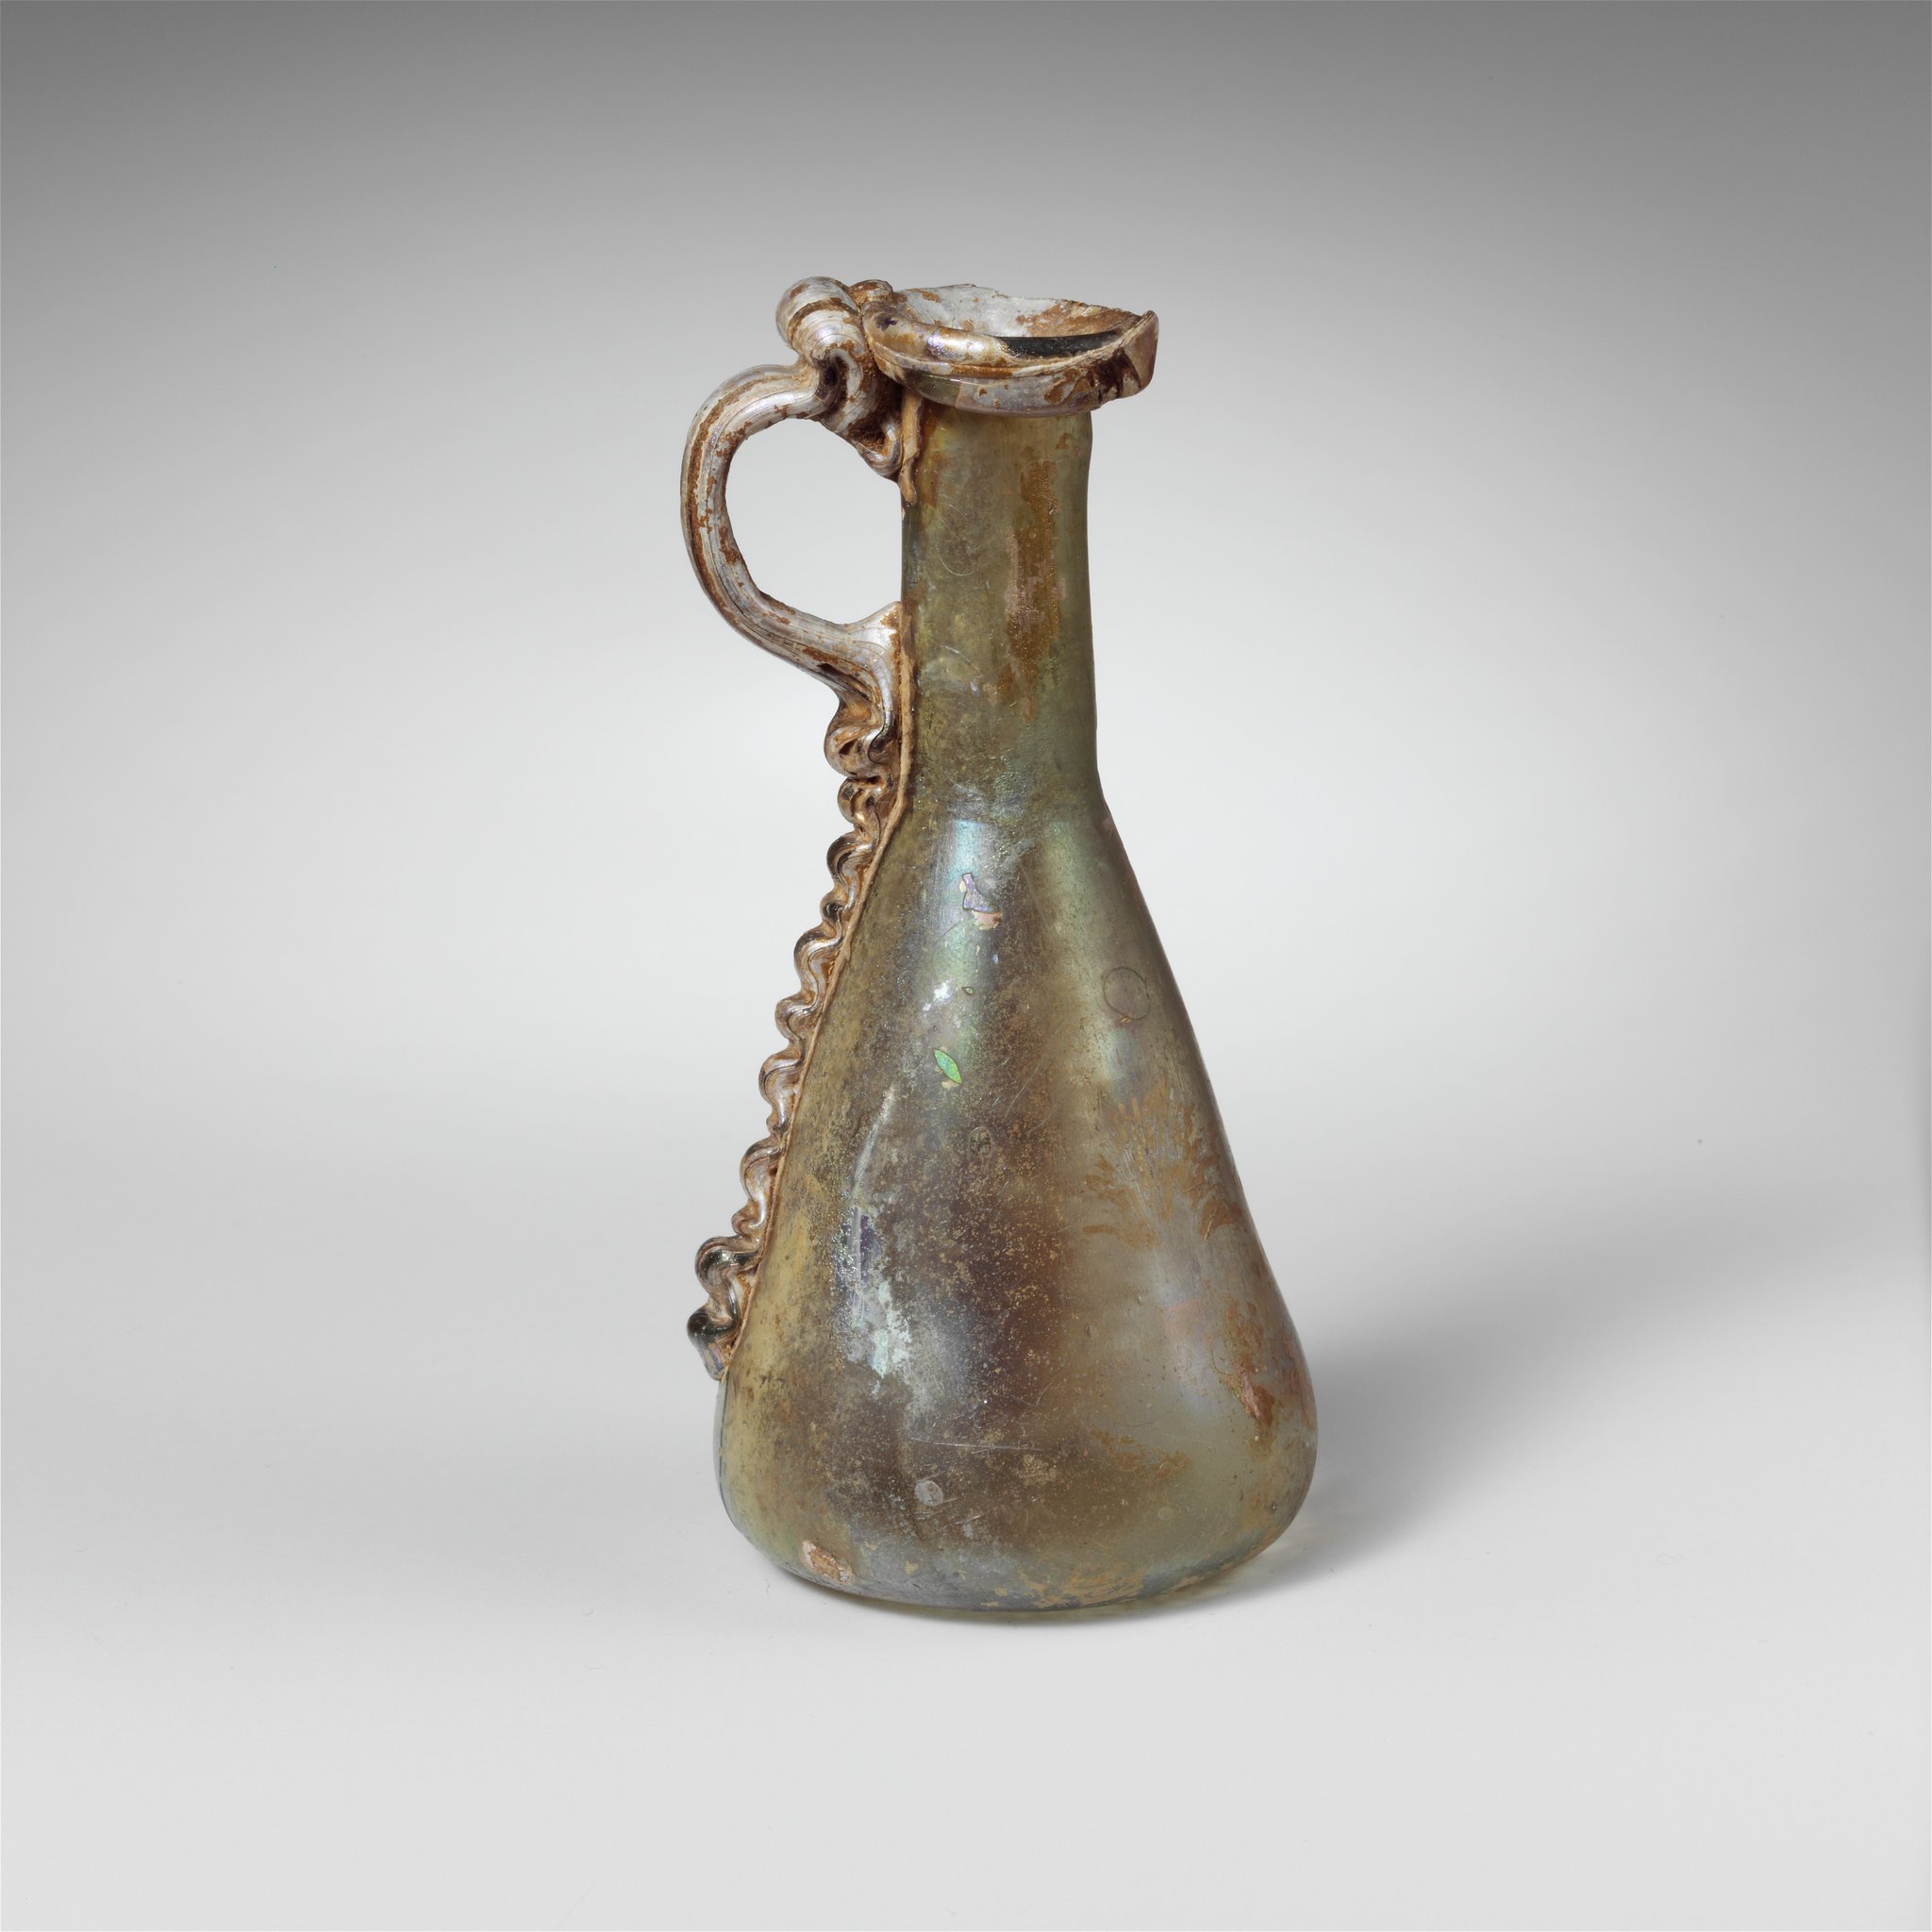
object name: jug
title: Glass jug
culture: roman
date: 1-200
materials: glass